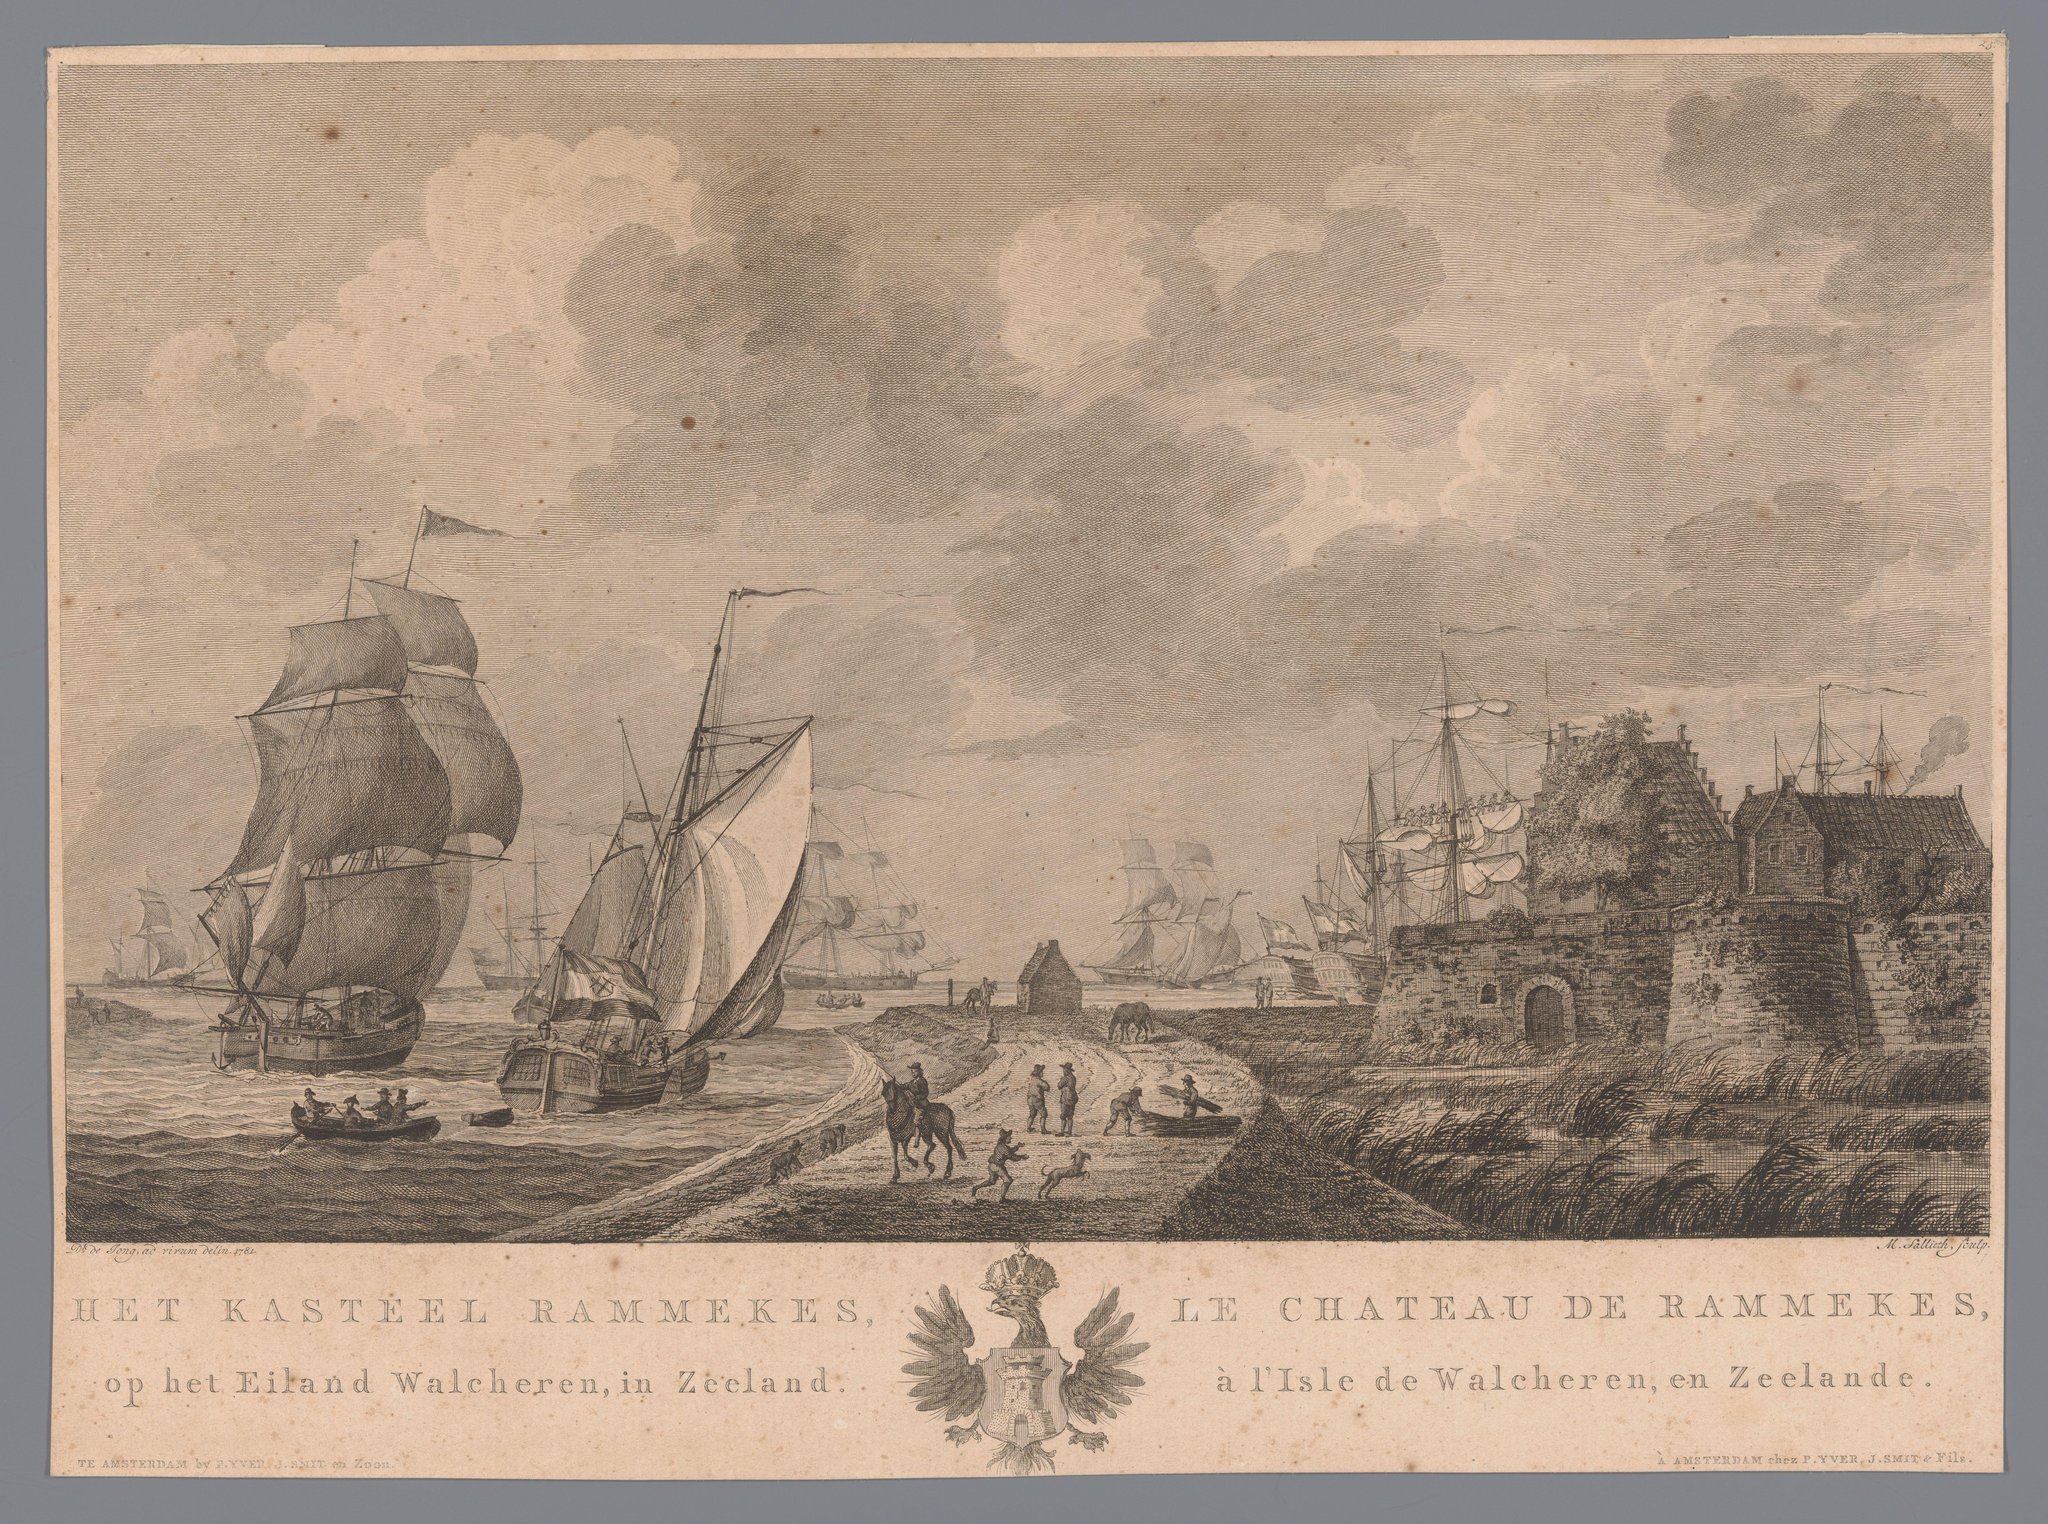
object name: print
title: Het Kasteel Rammekes, op het Eiland Walcheren, in Zeeland / Le Chateau de Rammekes, a l'Isle de Walcheren, en Zeelande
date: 1781-1787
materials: paper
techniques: etching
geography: amsterdam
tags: fortress, sailing-ship, sailing-boat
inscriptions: collector's mark: Lugt 2228